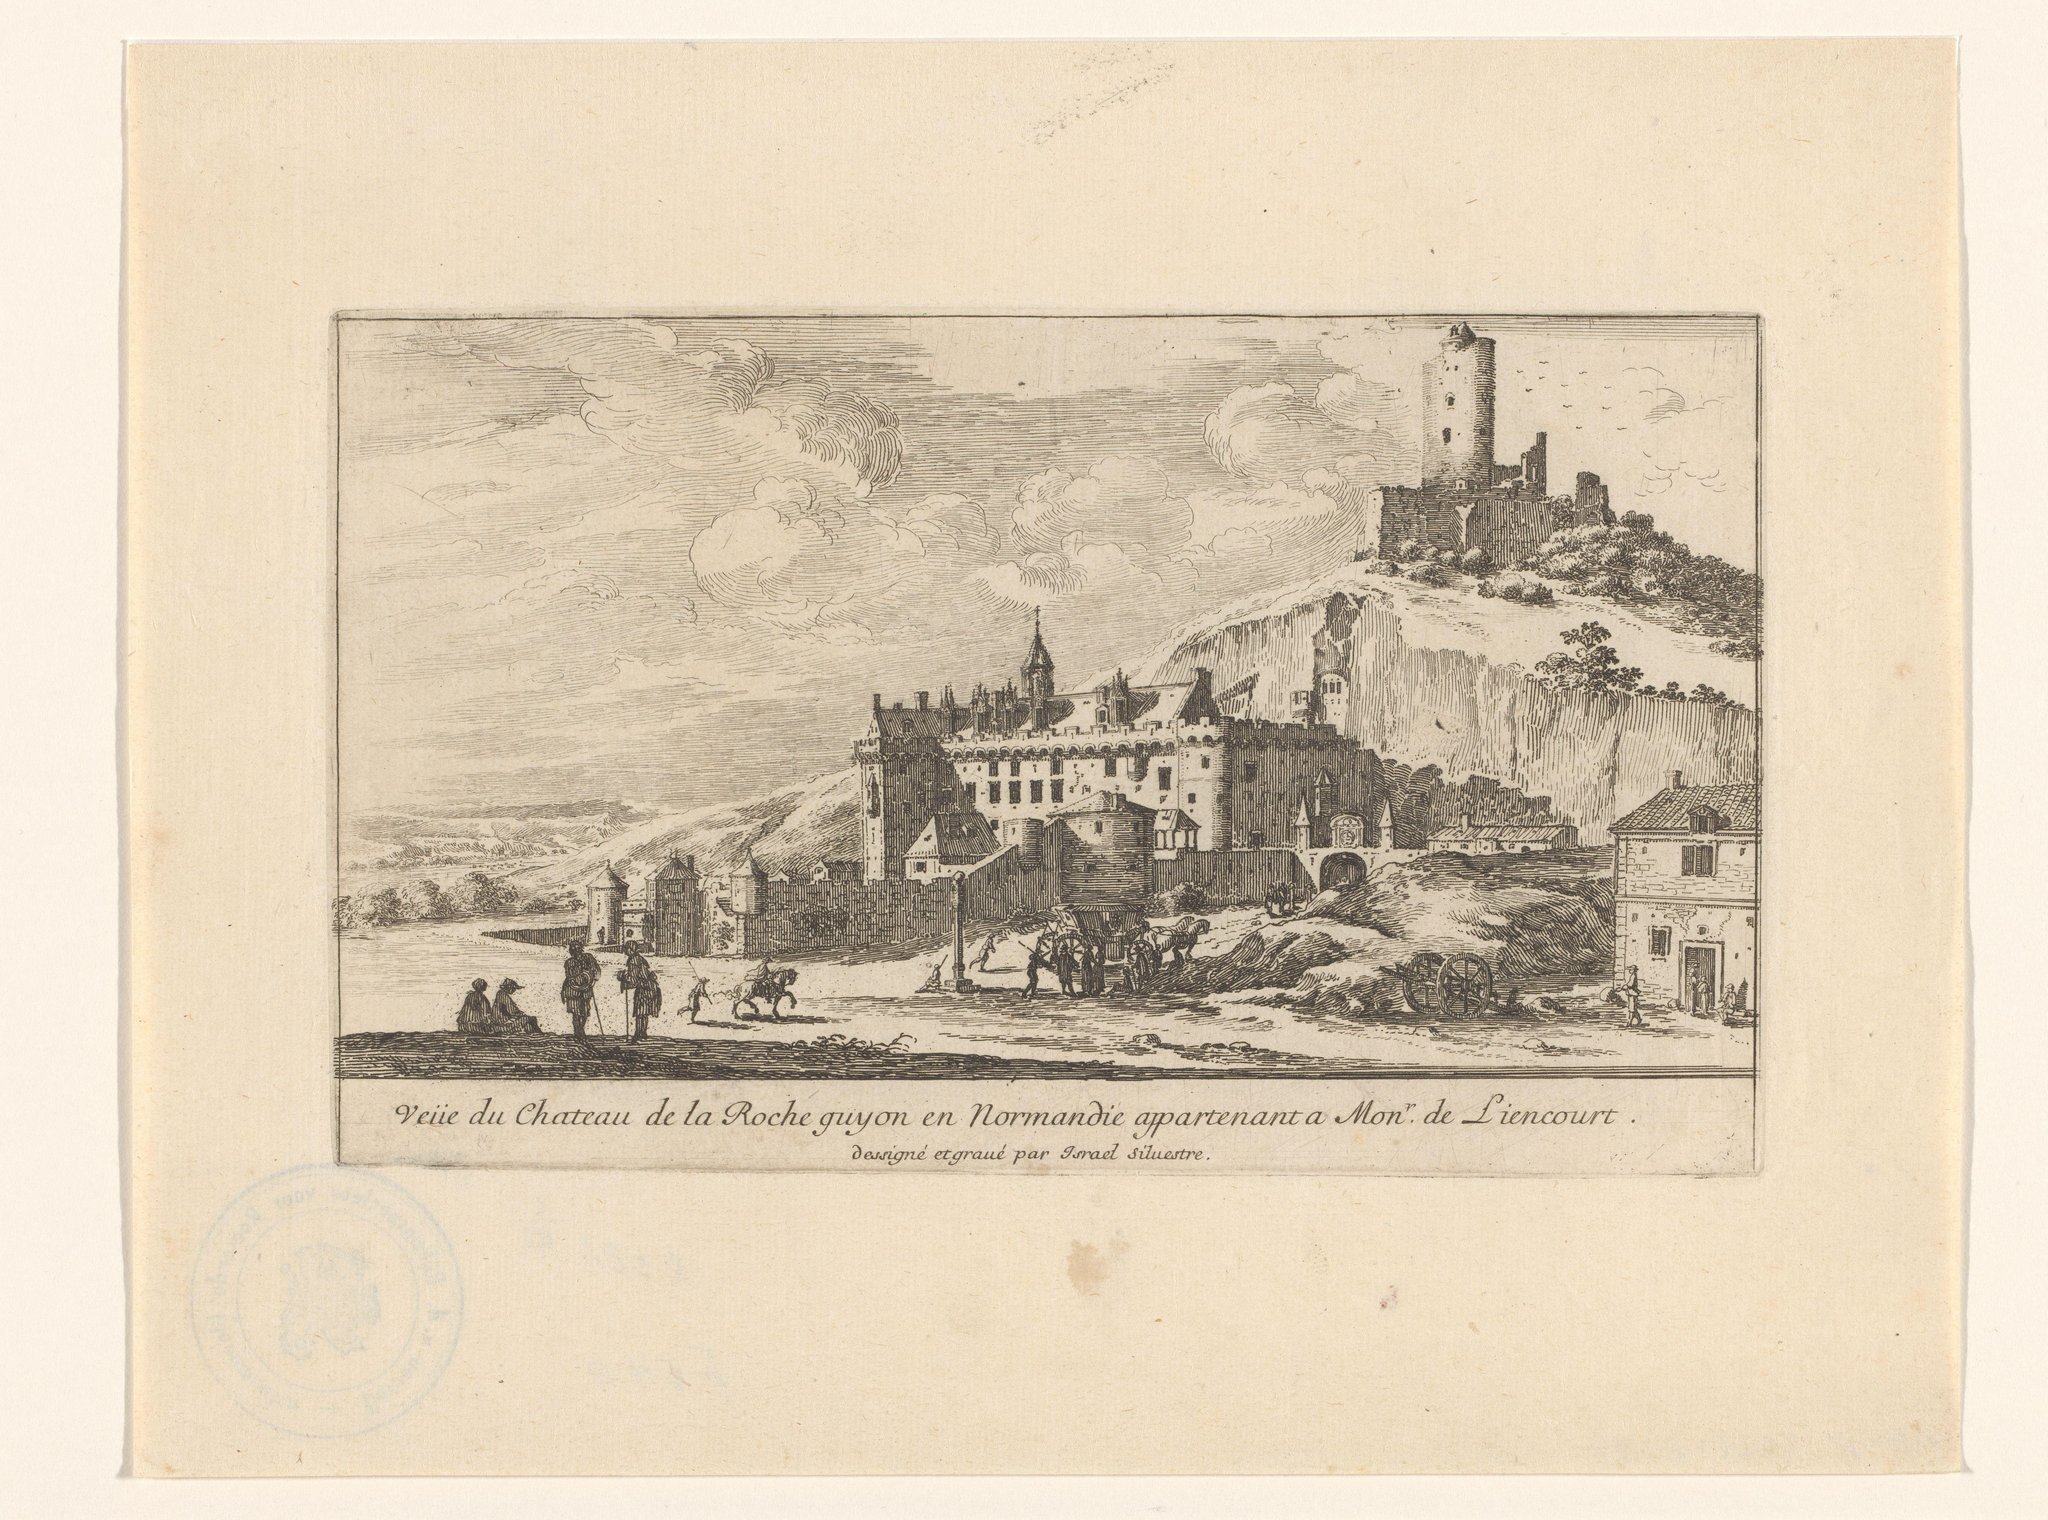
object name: print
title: Diverses Veües faites sur le Naturel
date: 1658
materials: paper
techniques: etching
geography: france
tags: river, (high) hill, landscape with tower or castle (+ city(-scape) with figures, staffage)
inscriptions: stamp: ‘Bureau v.d. Rijksinspecteur voor Roerende Monumenten ’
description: Prent maakt deel uit van een ongenummerde serie van tien prenten.